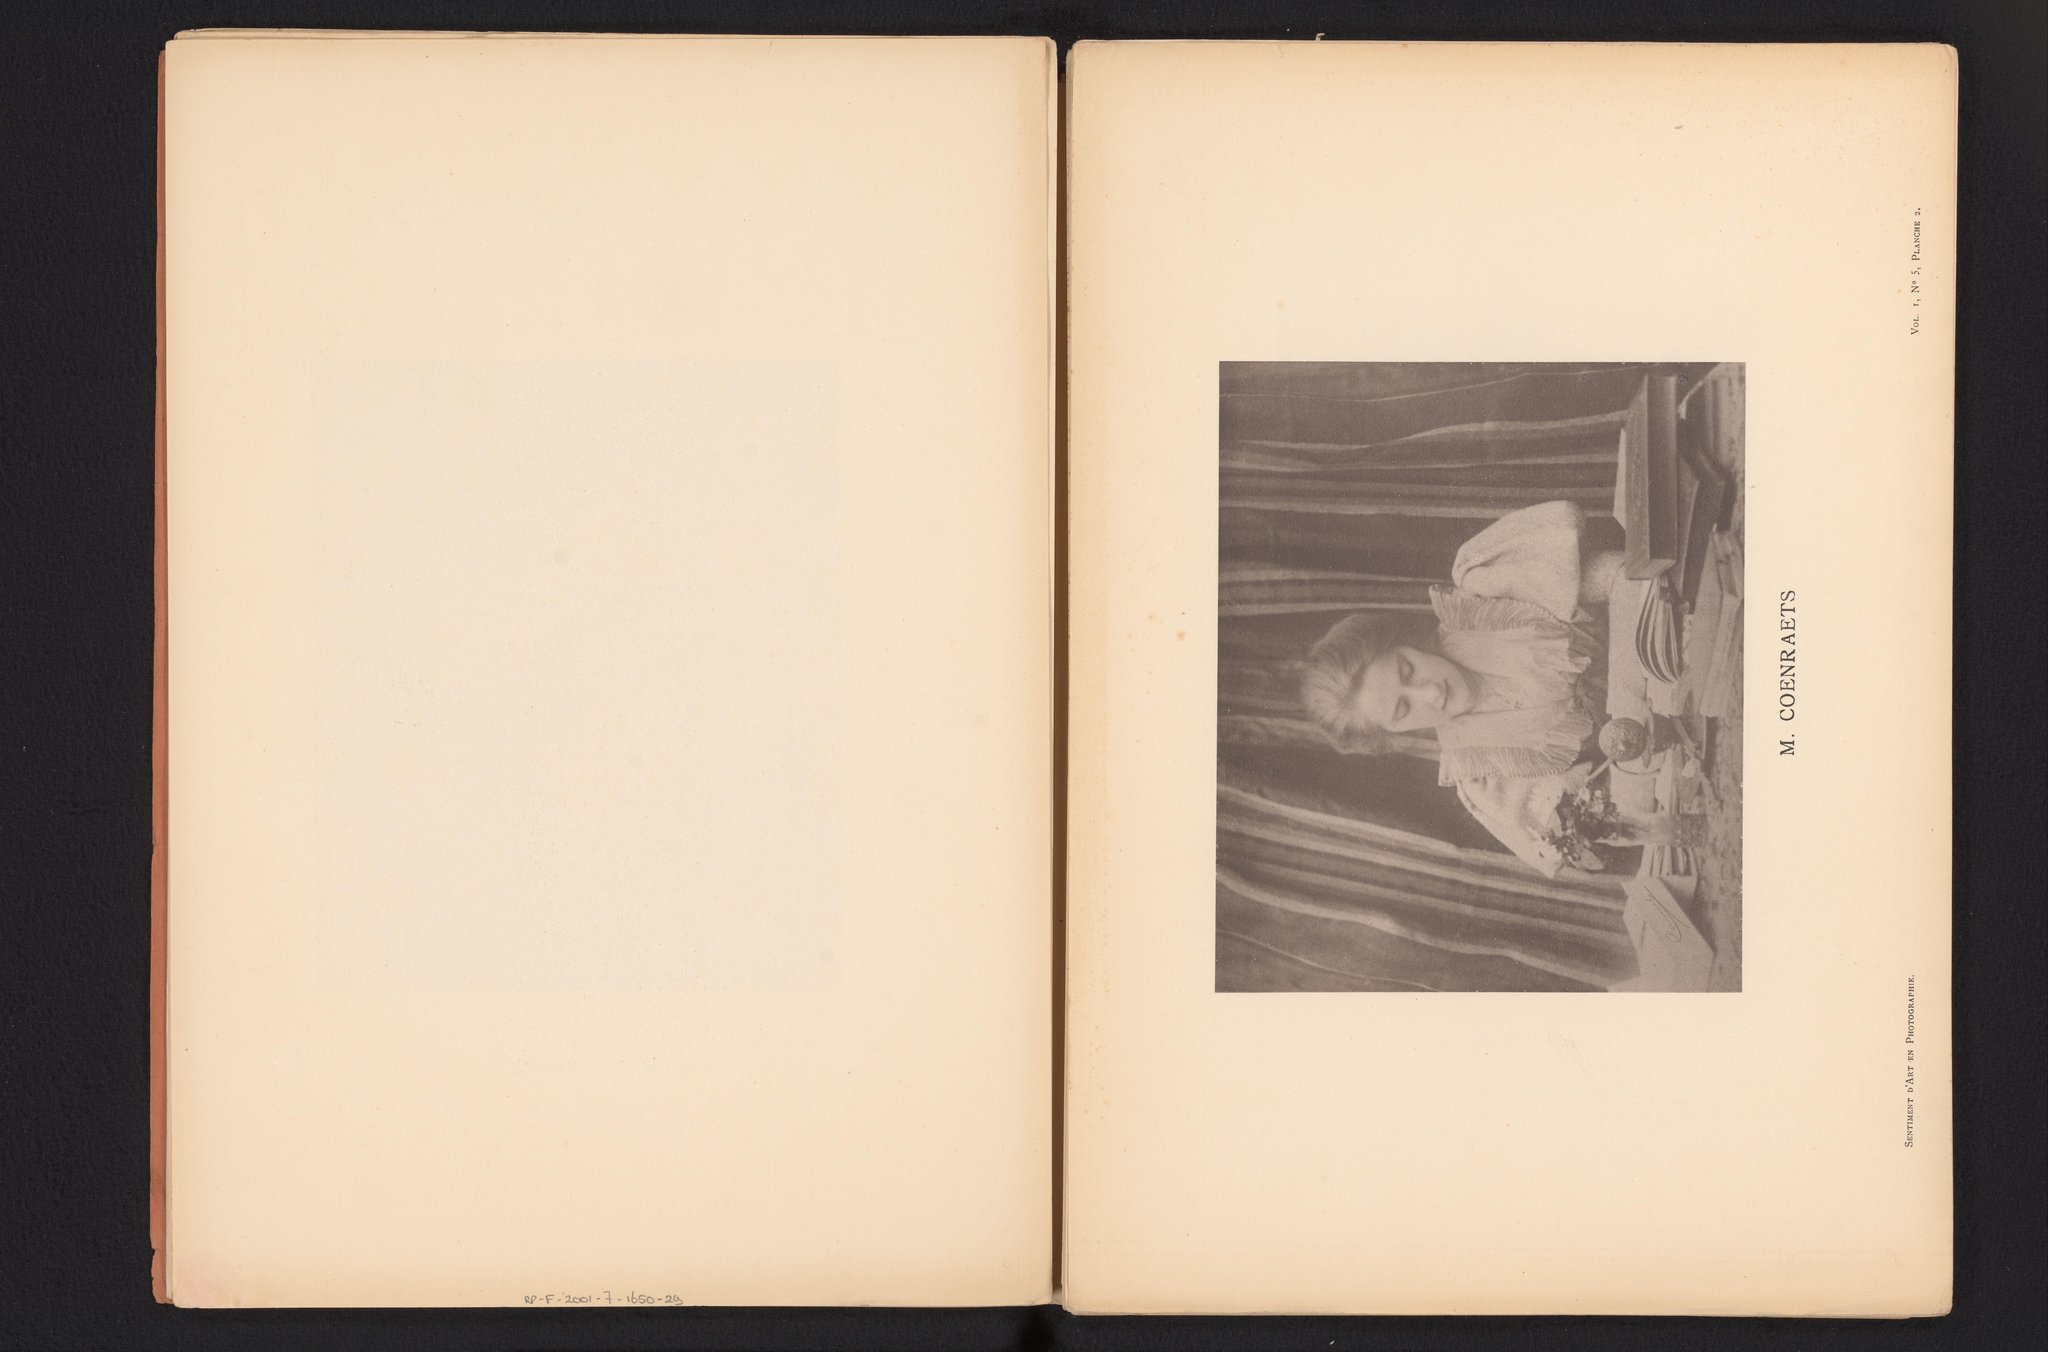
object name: photomechanical print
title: Sentiment d'Art en Photographie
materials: paper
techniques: photograph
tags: adult woman, reading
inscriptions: number: ‘Vol. 1, No 5, Planche 2.’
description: Deze prent maakt deel uit van 8 omslagen met 22 tekstbladen en 89 prenten op losse bladen in en tussen de omslagen.